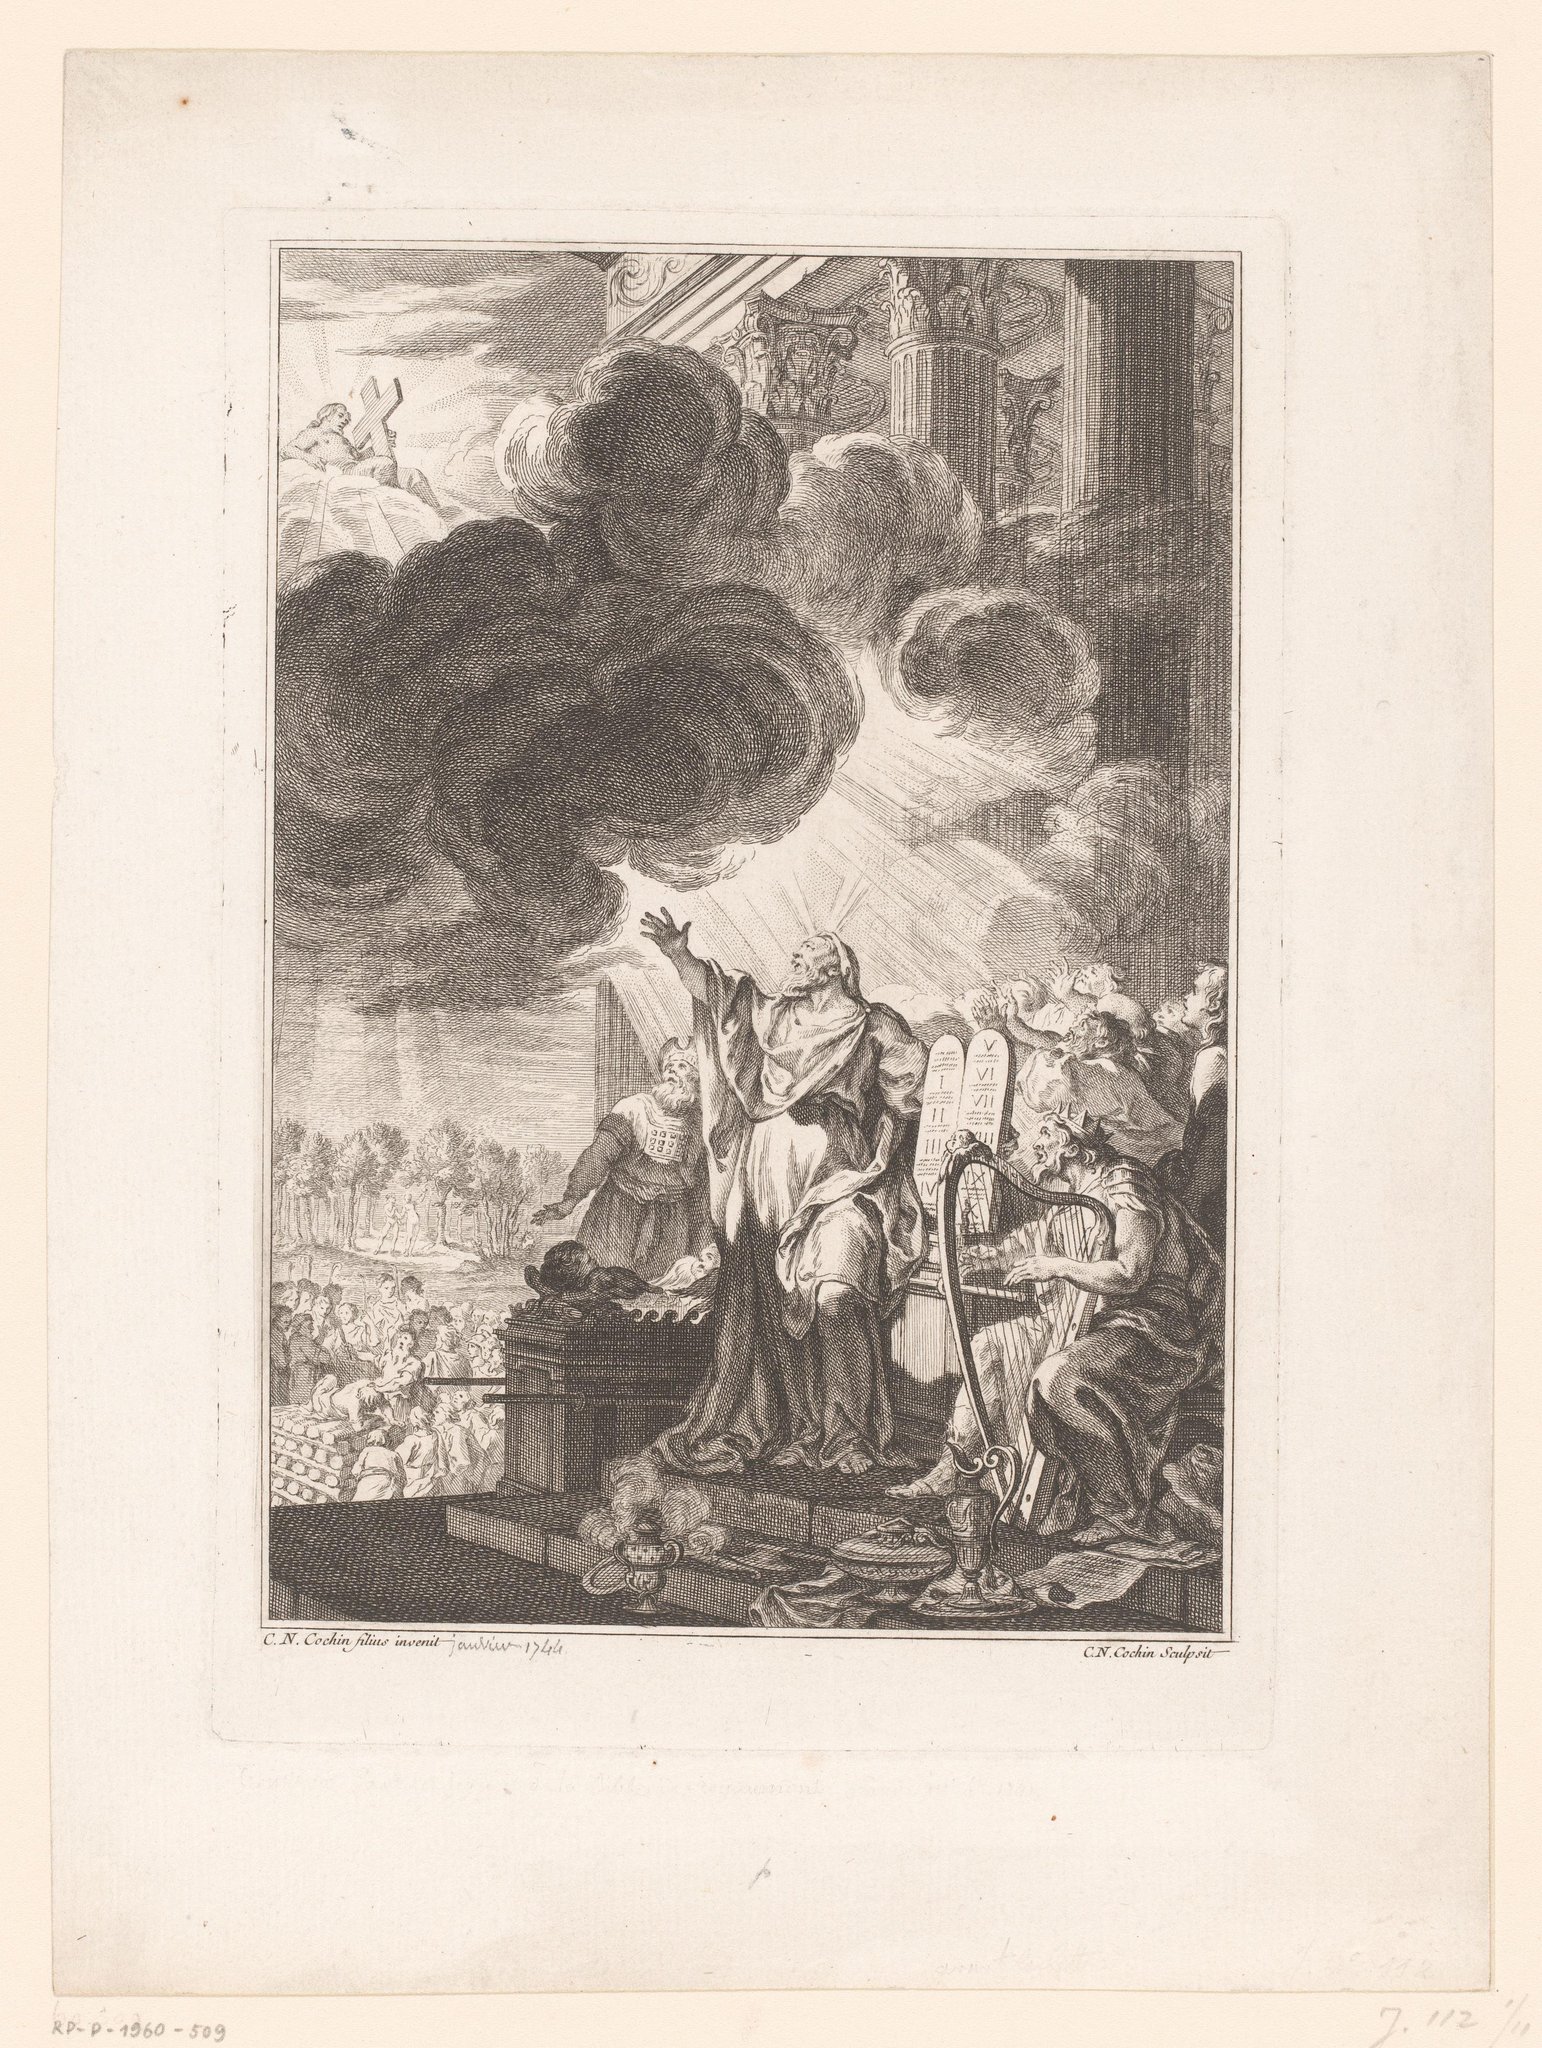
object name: titelblad, titelpagina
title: Titelpagina voor: s.n., Bible de Royaumont, 1744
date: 1744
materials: paper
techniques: engraving, etching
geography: france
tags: (adult) christ appearing to mortals, adam and eve in paradise (before the fall), david as musician, usually playing the harp, moses receives the tables of the law from god, abraham picks up the knife to kill isaac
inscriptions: collector's mark: Lugt 2228, inscription: ‘janvier 1744’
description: Op de voorgrond Mozes met de tien geboden, naast hem zit koning David met zijn harp en op de achtergrond staan Adam en Eva en staat Abraham op het punt Isaac te offeren. Deze scènes worden onderbroken door de verschijning van Christus vanop een wolk.